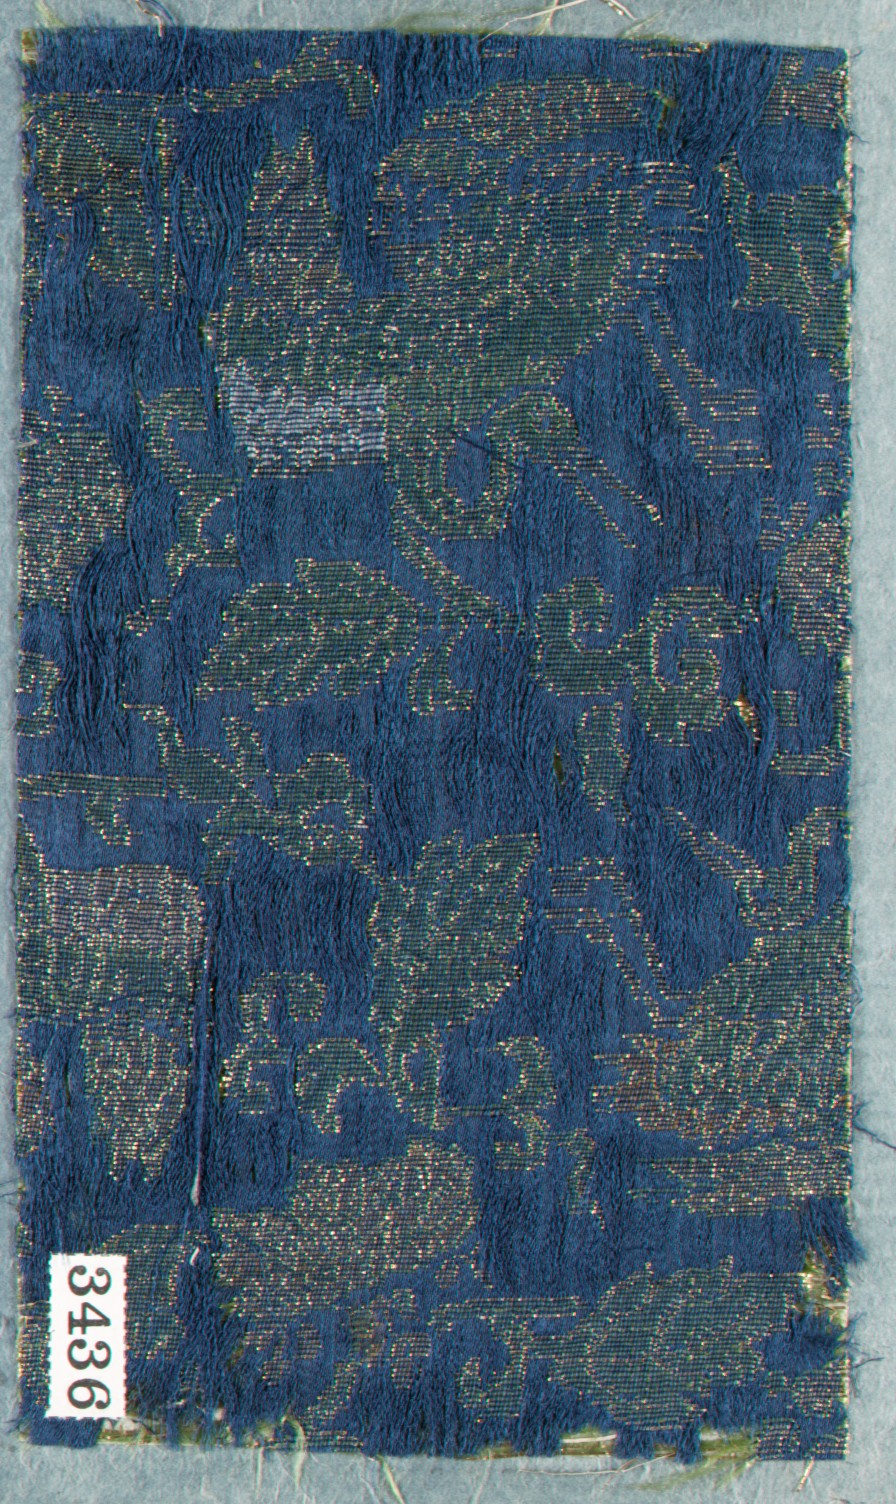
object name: textile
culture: japanese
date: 1801-1900